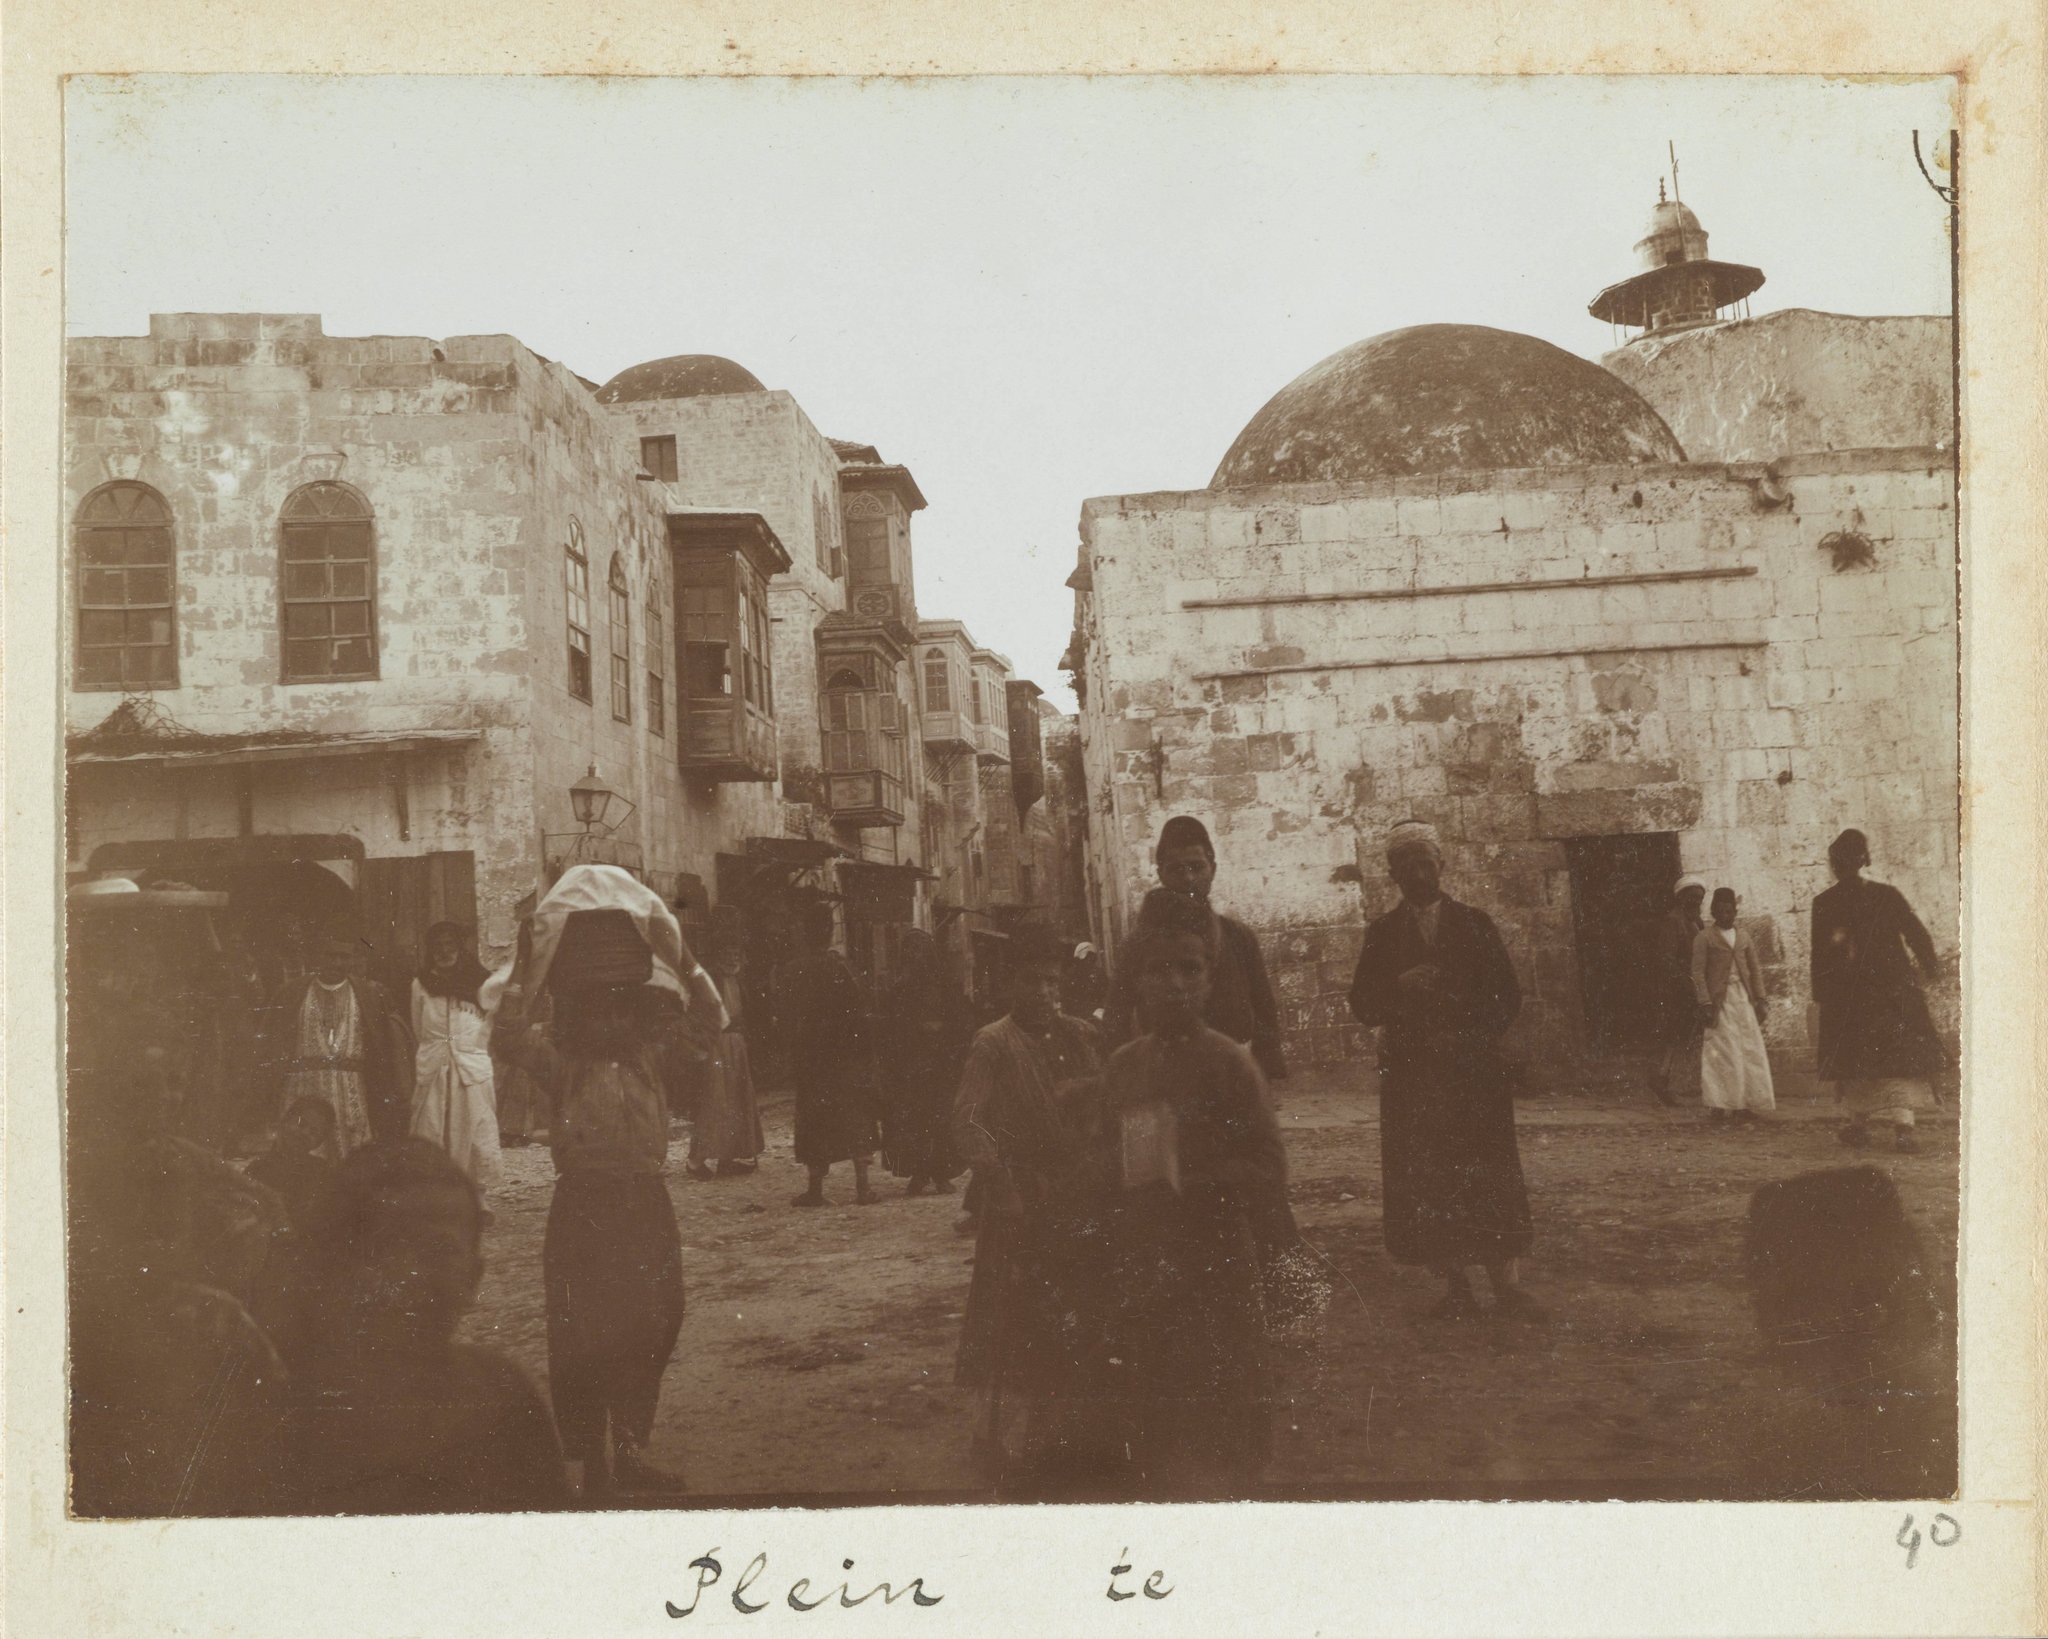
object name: photograph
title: Plein te Nabulus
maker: johannes lodewijk heldring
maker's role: fotograaf, predikant, schrijver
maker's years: 1852-1923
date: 1898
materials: paper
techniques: collodion silver print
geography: nablus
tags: square, place, circus, etc.